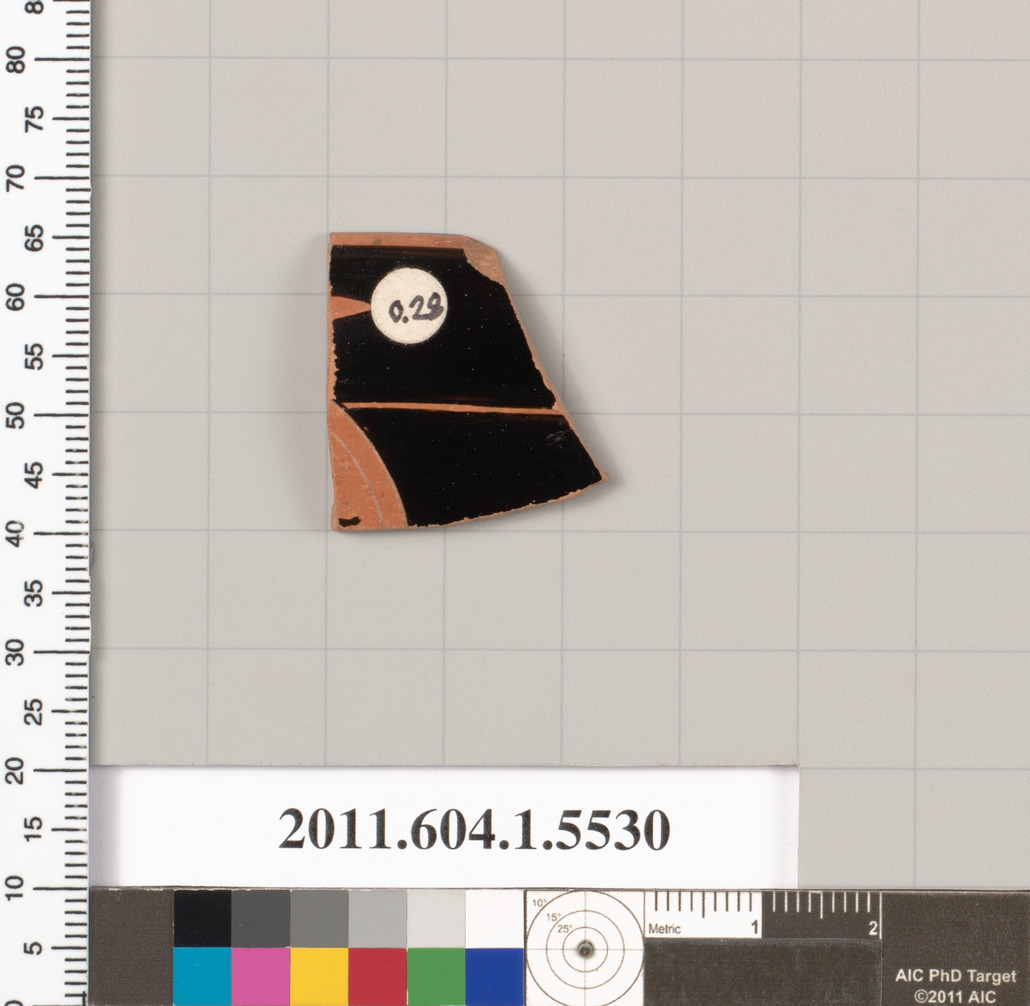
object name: kylix fragment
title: Terracotta rim fragment of a kylix (drinking cup)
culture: greek, attic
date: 520-500 BCE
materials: terracotta